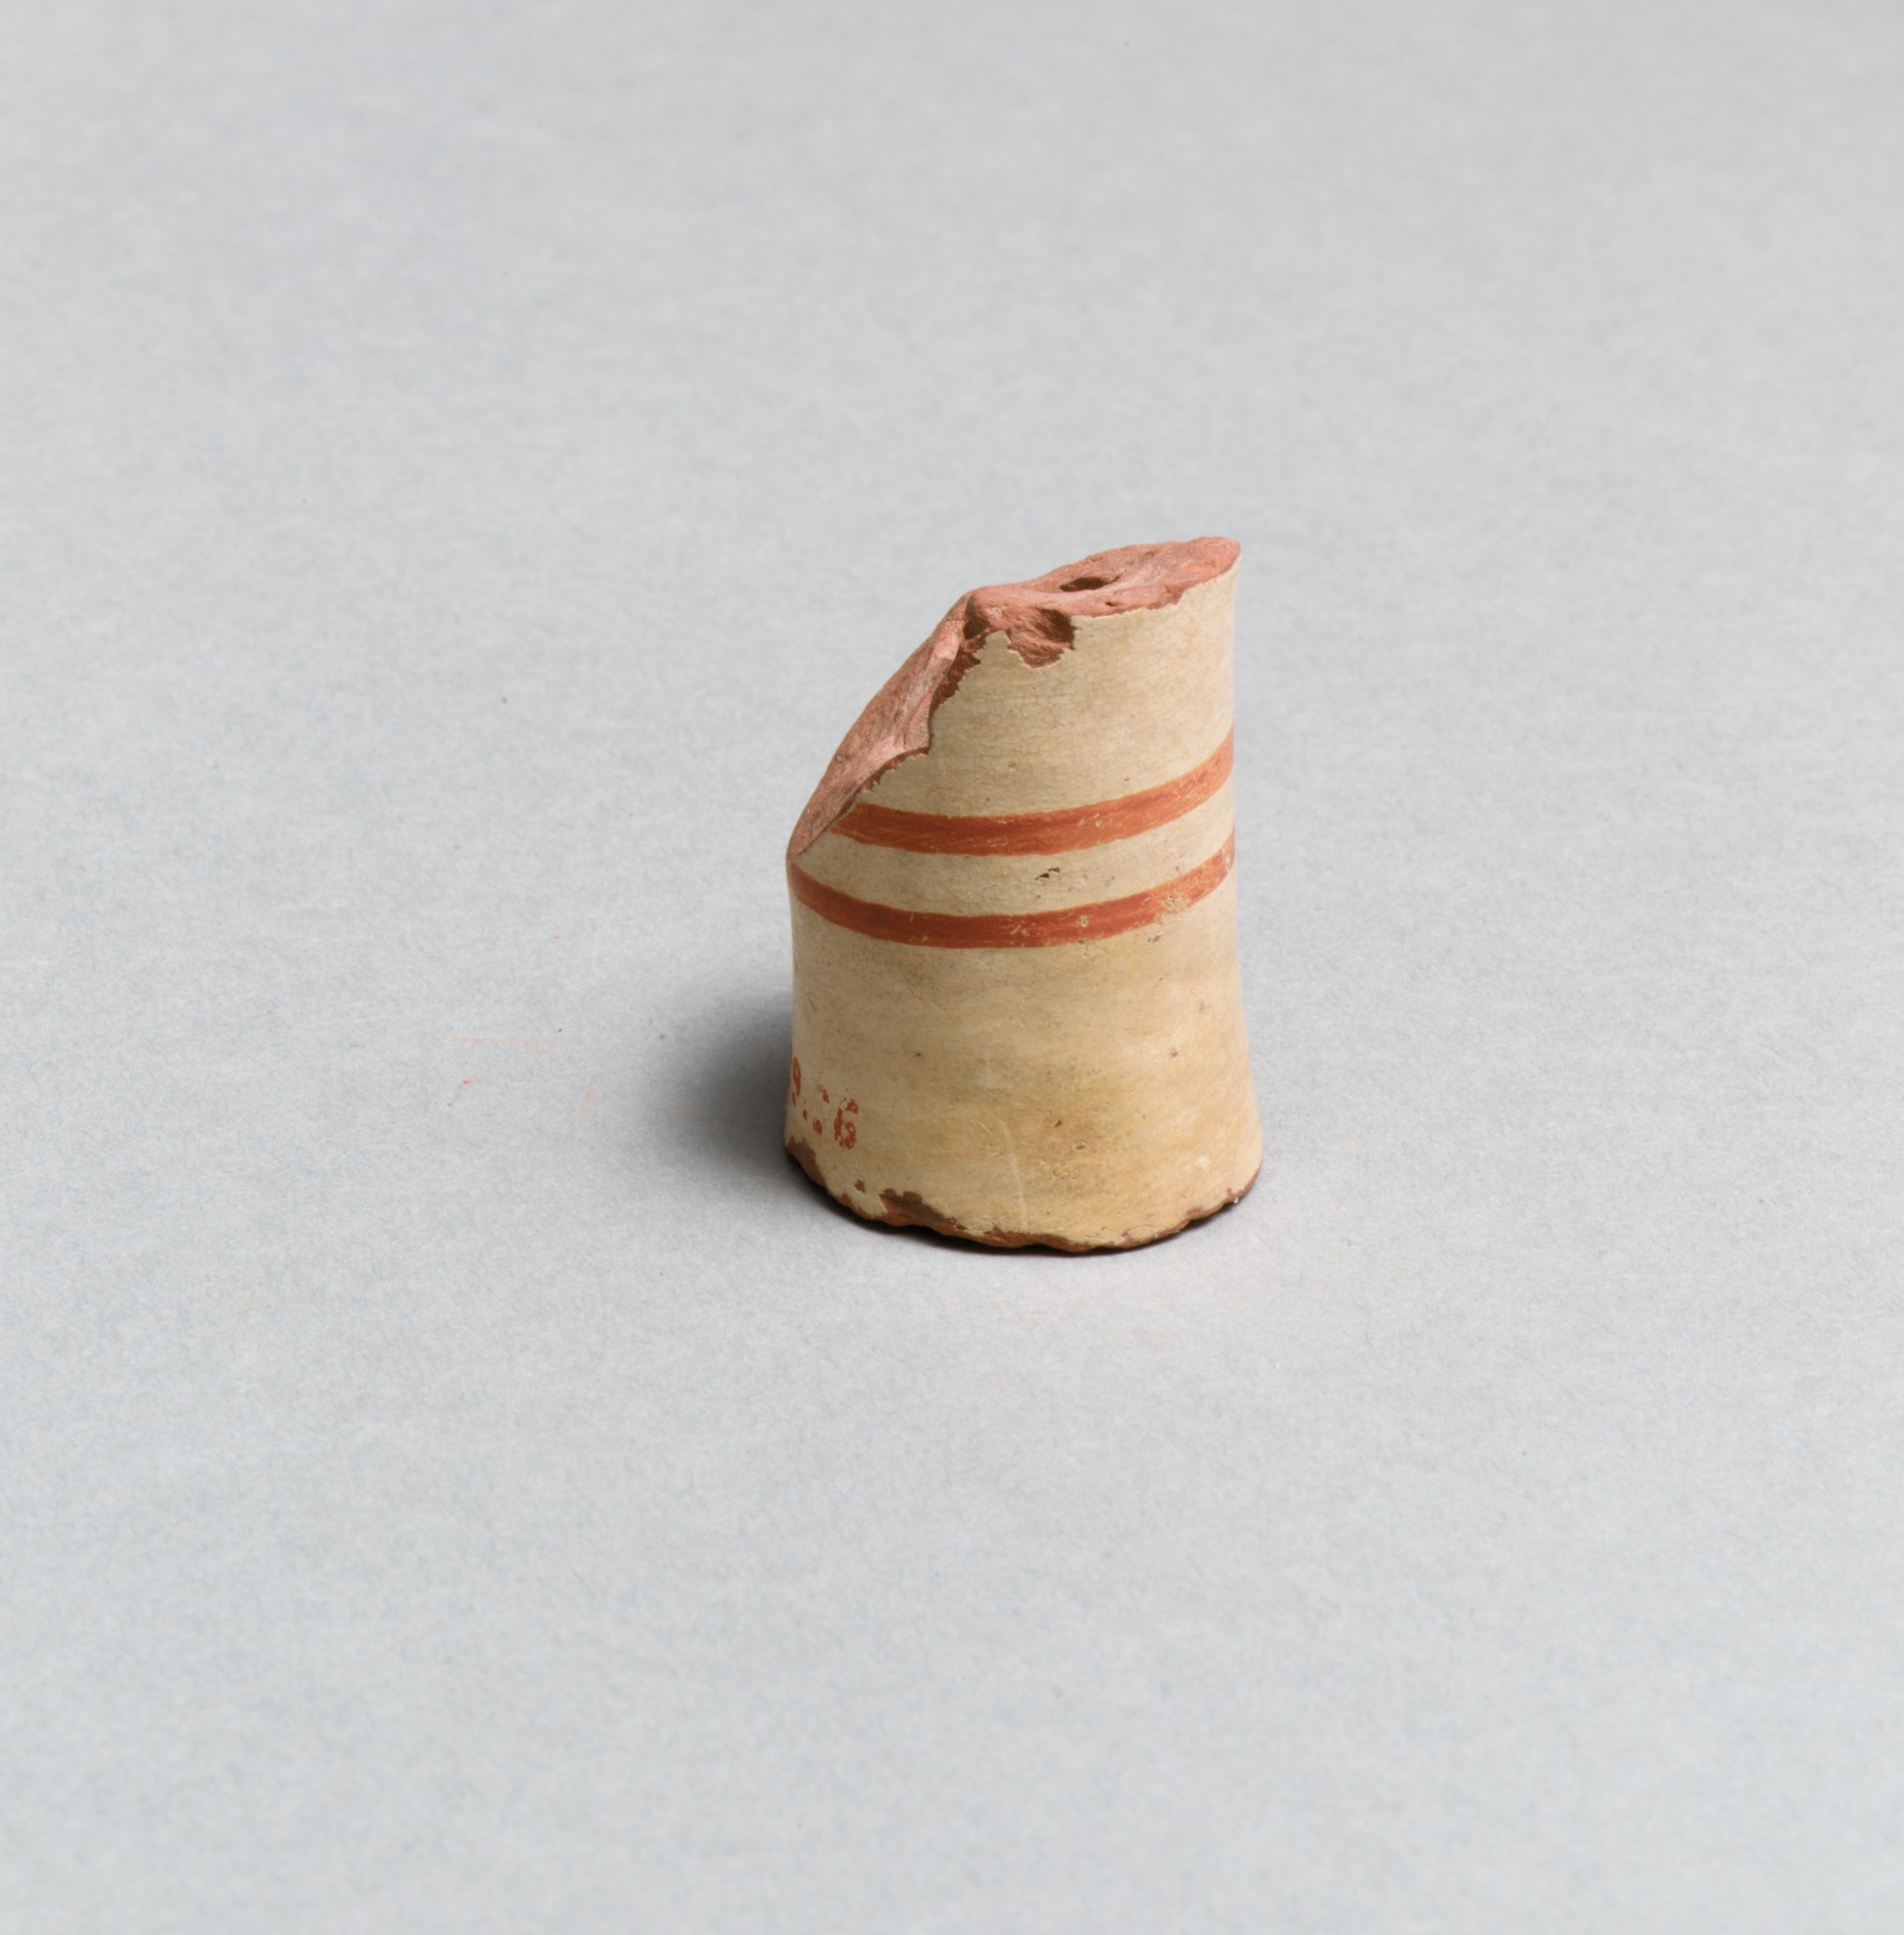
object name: vase fragment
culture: greek or lydian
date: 900-30 BCE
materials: terracotta